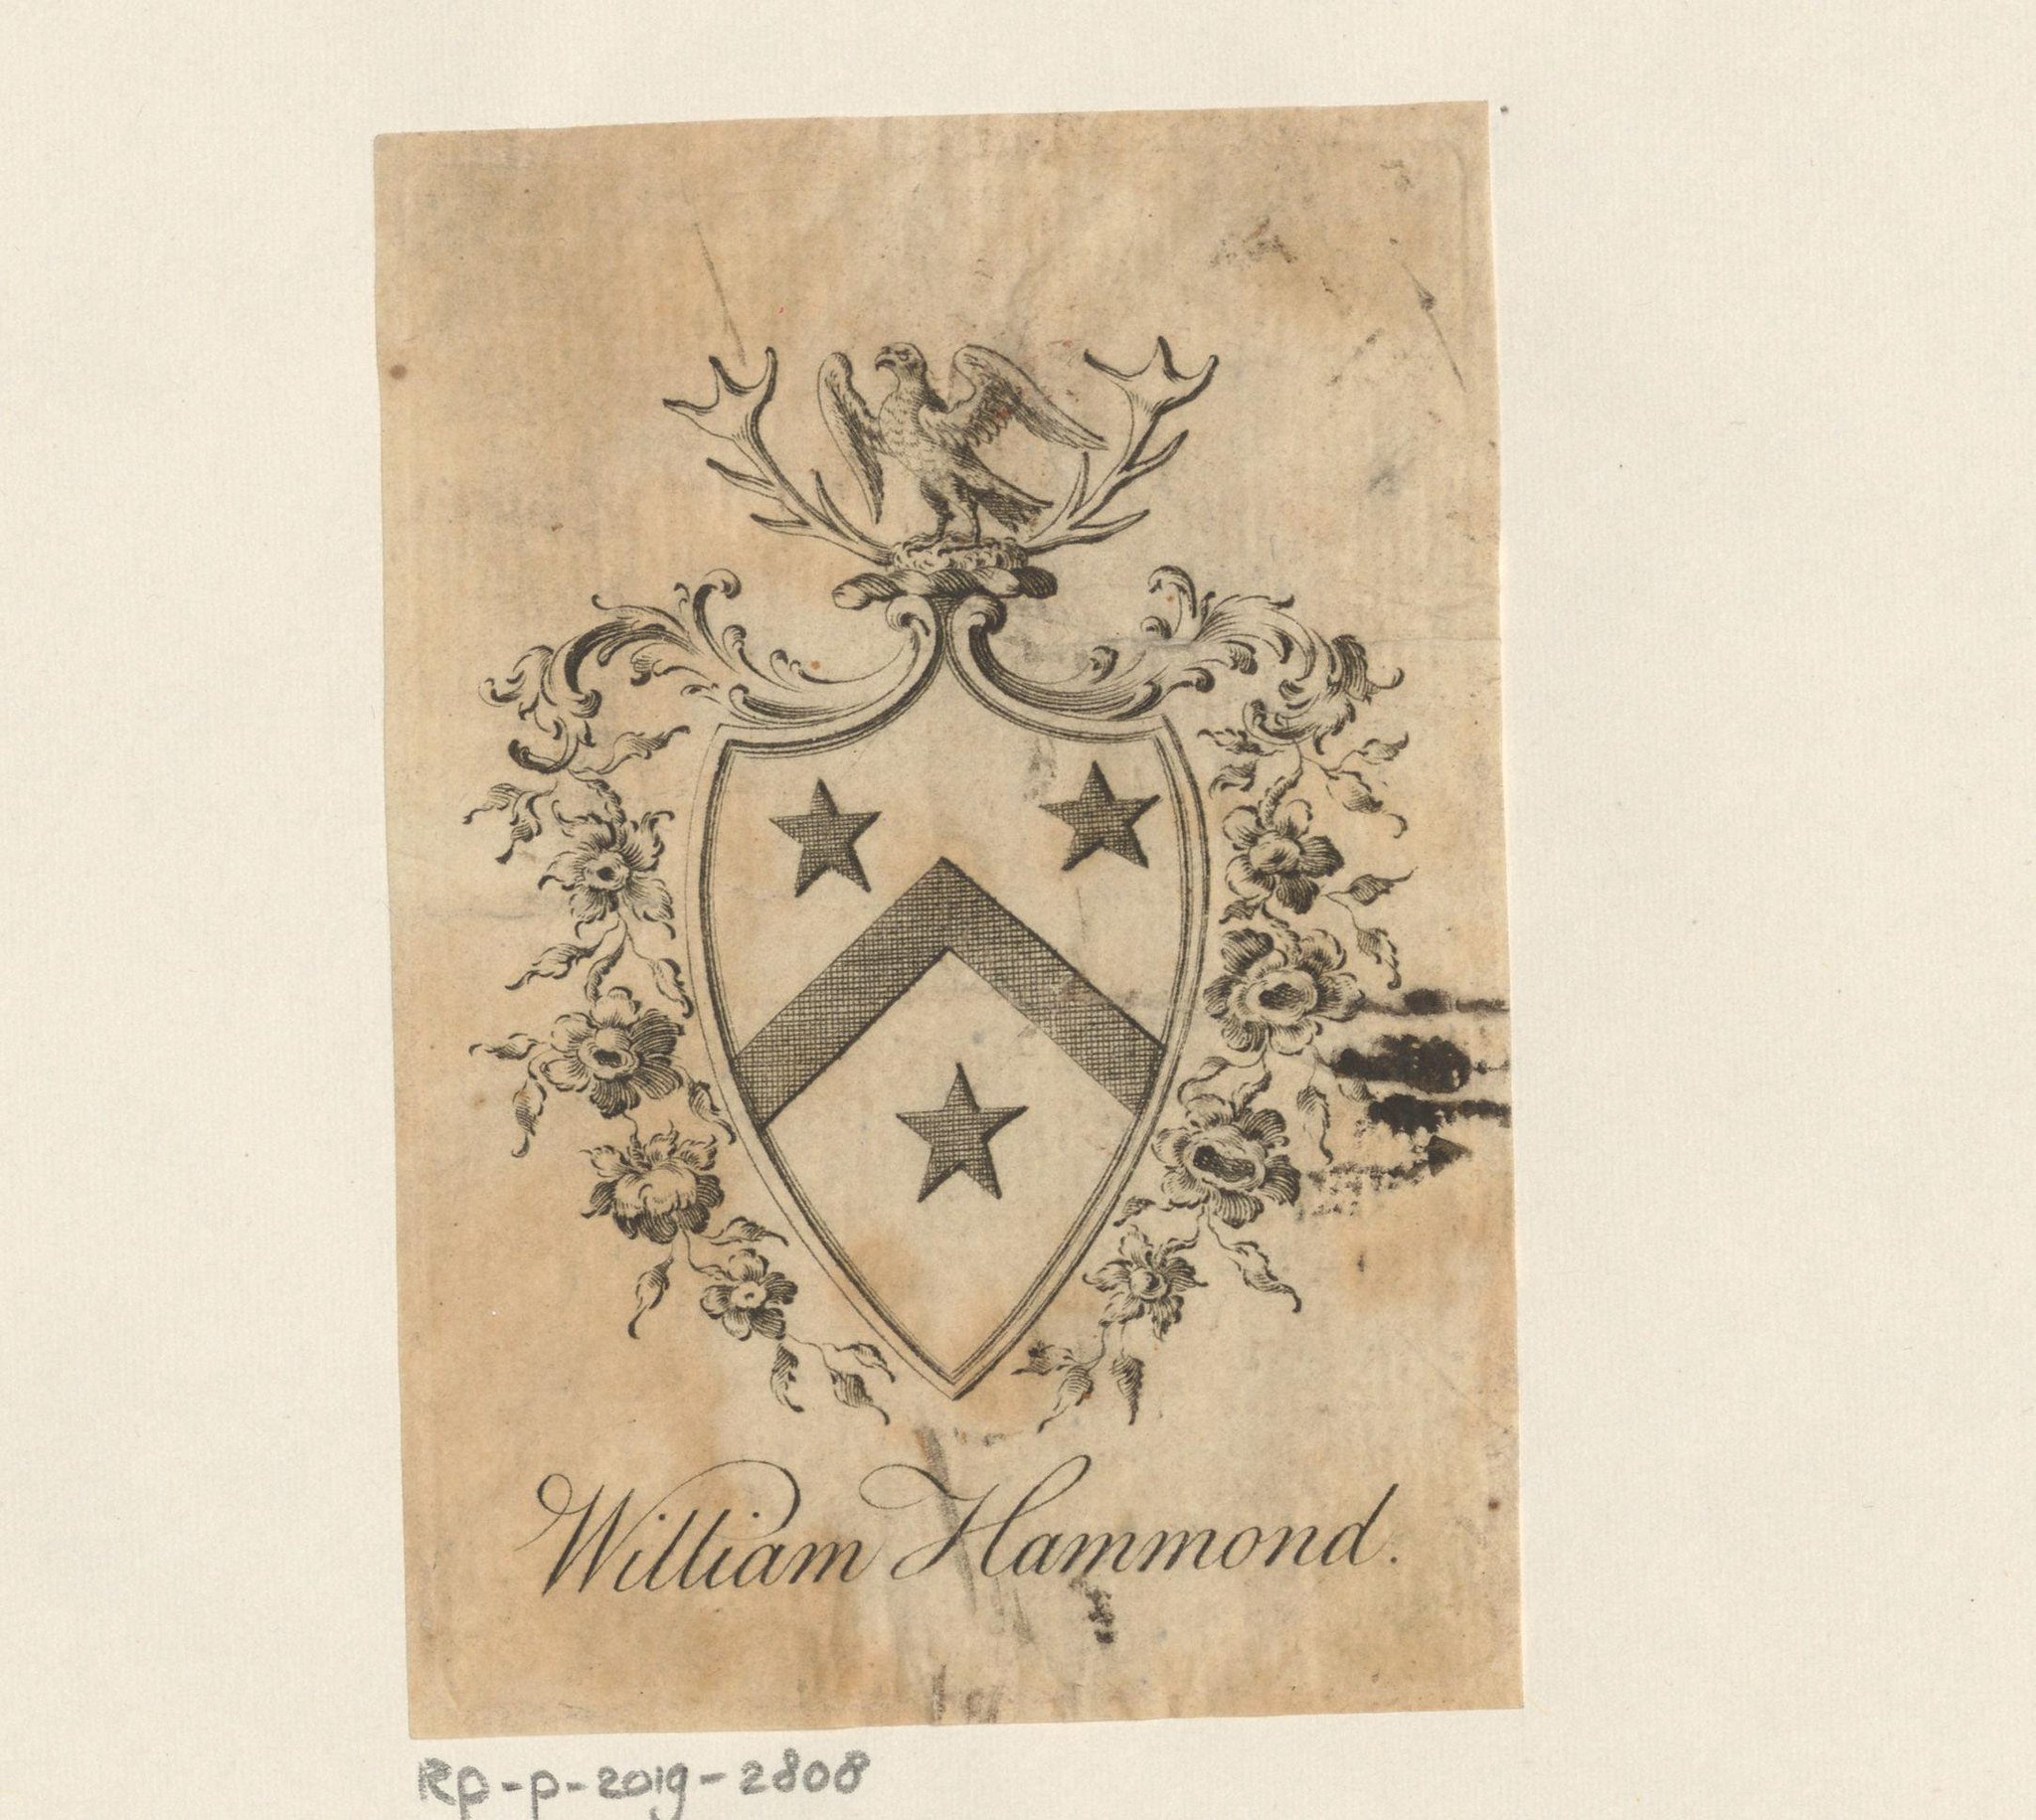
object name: bookplate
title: Ex libris van William Hammond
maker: Anonymous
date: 1750-1849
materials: paper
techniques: engraving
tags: armorial bearing, heraldry